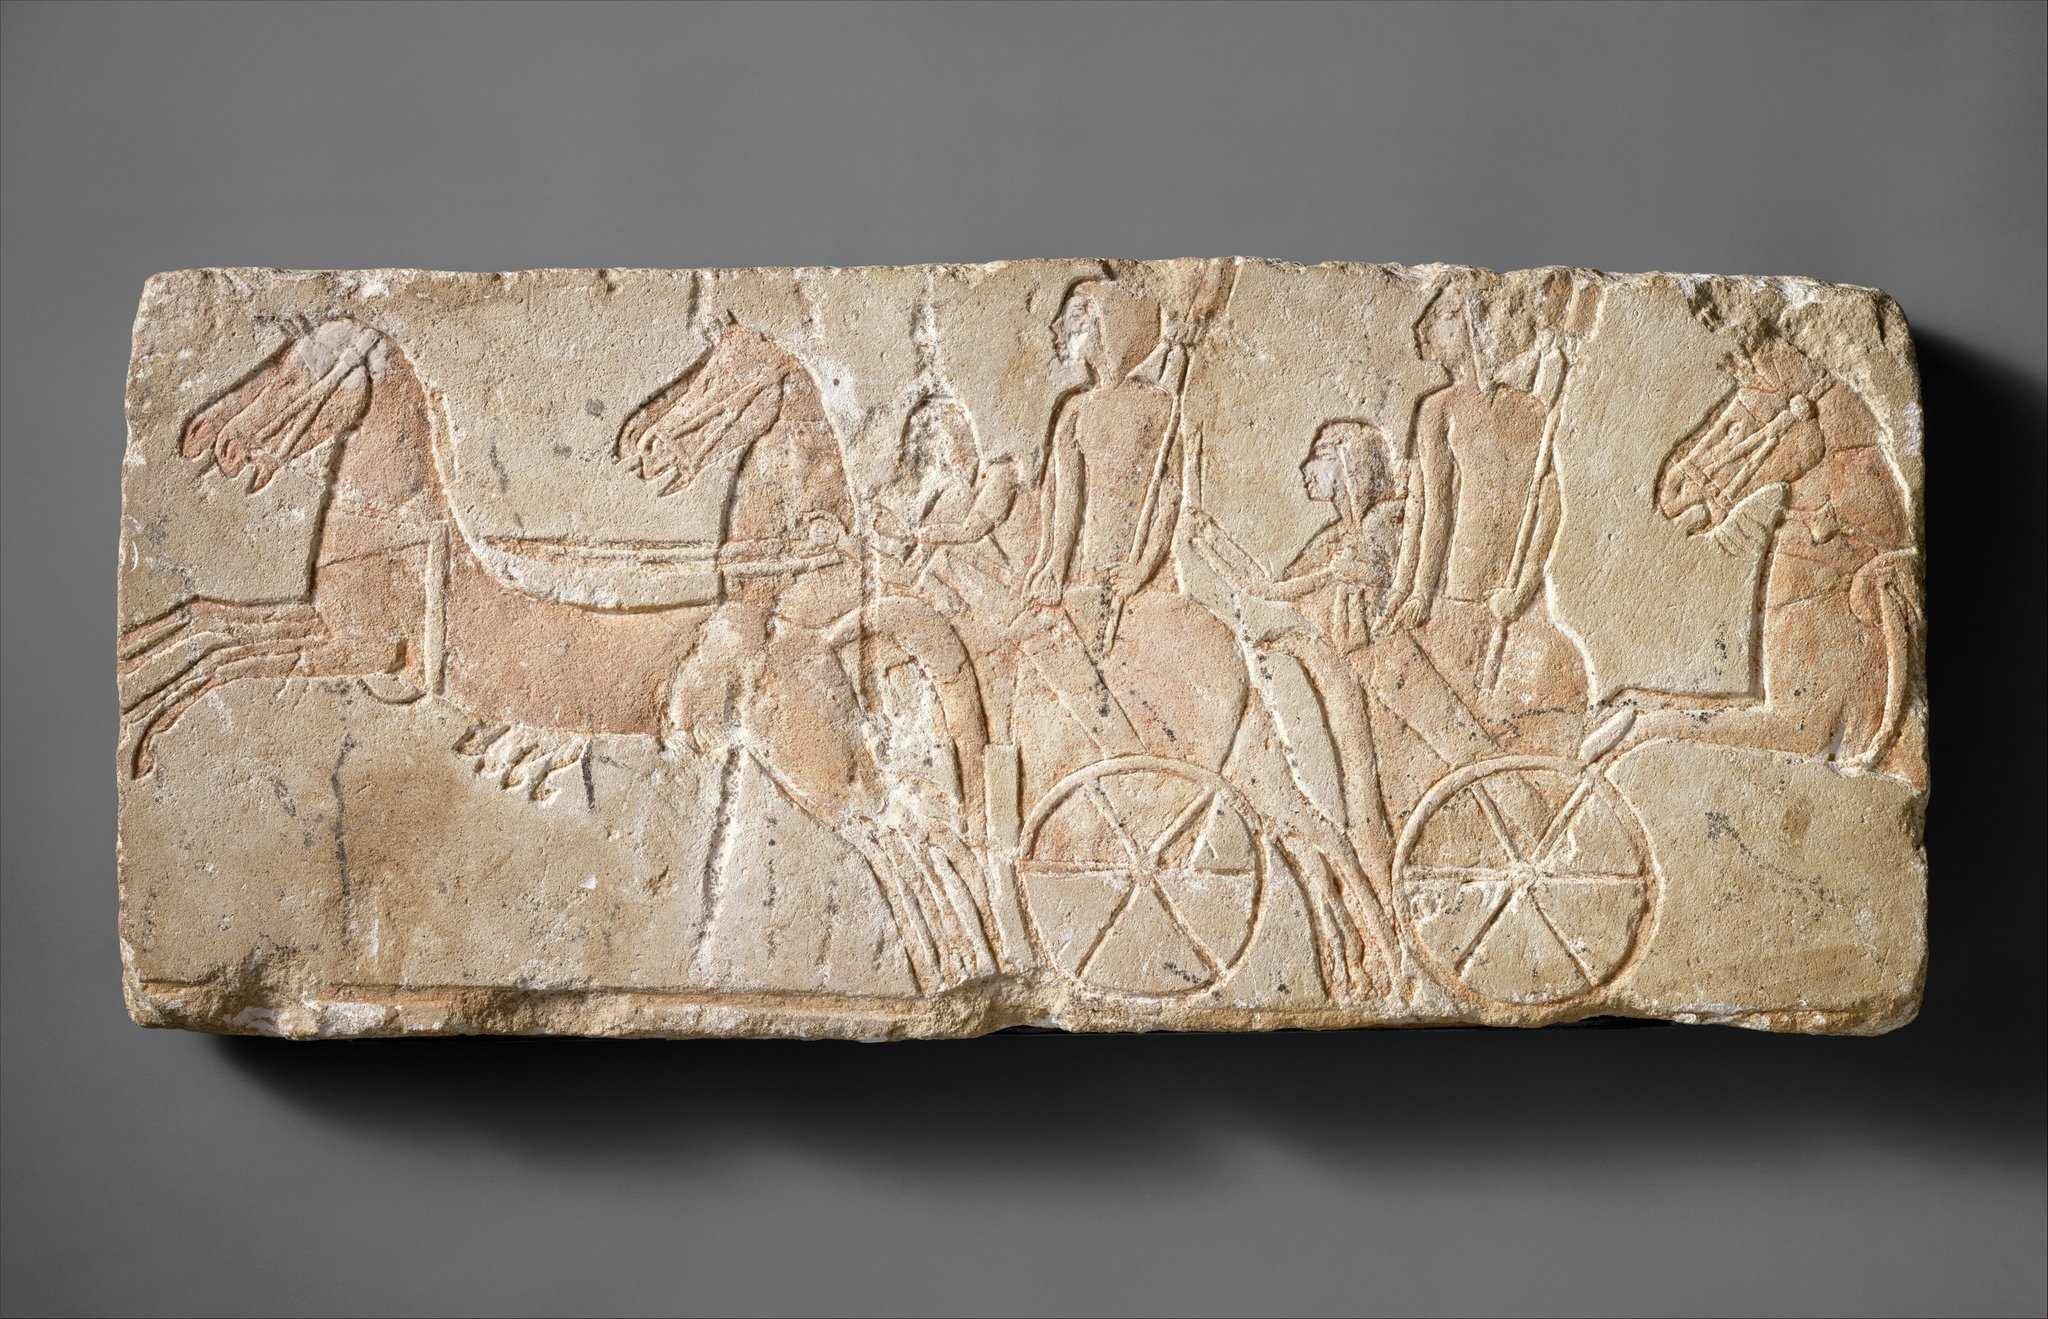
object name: talatat, chariot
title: Chariots with Court Ladies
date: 1353-1336 BCE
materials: limestone, paint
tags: women,horses,chariots